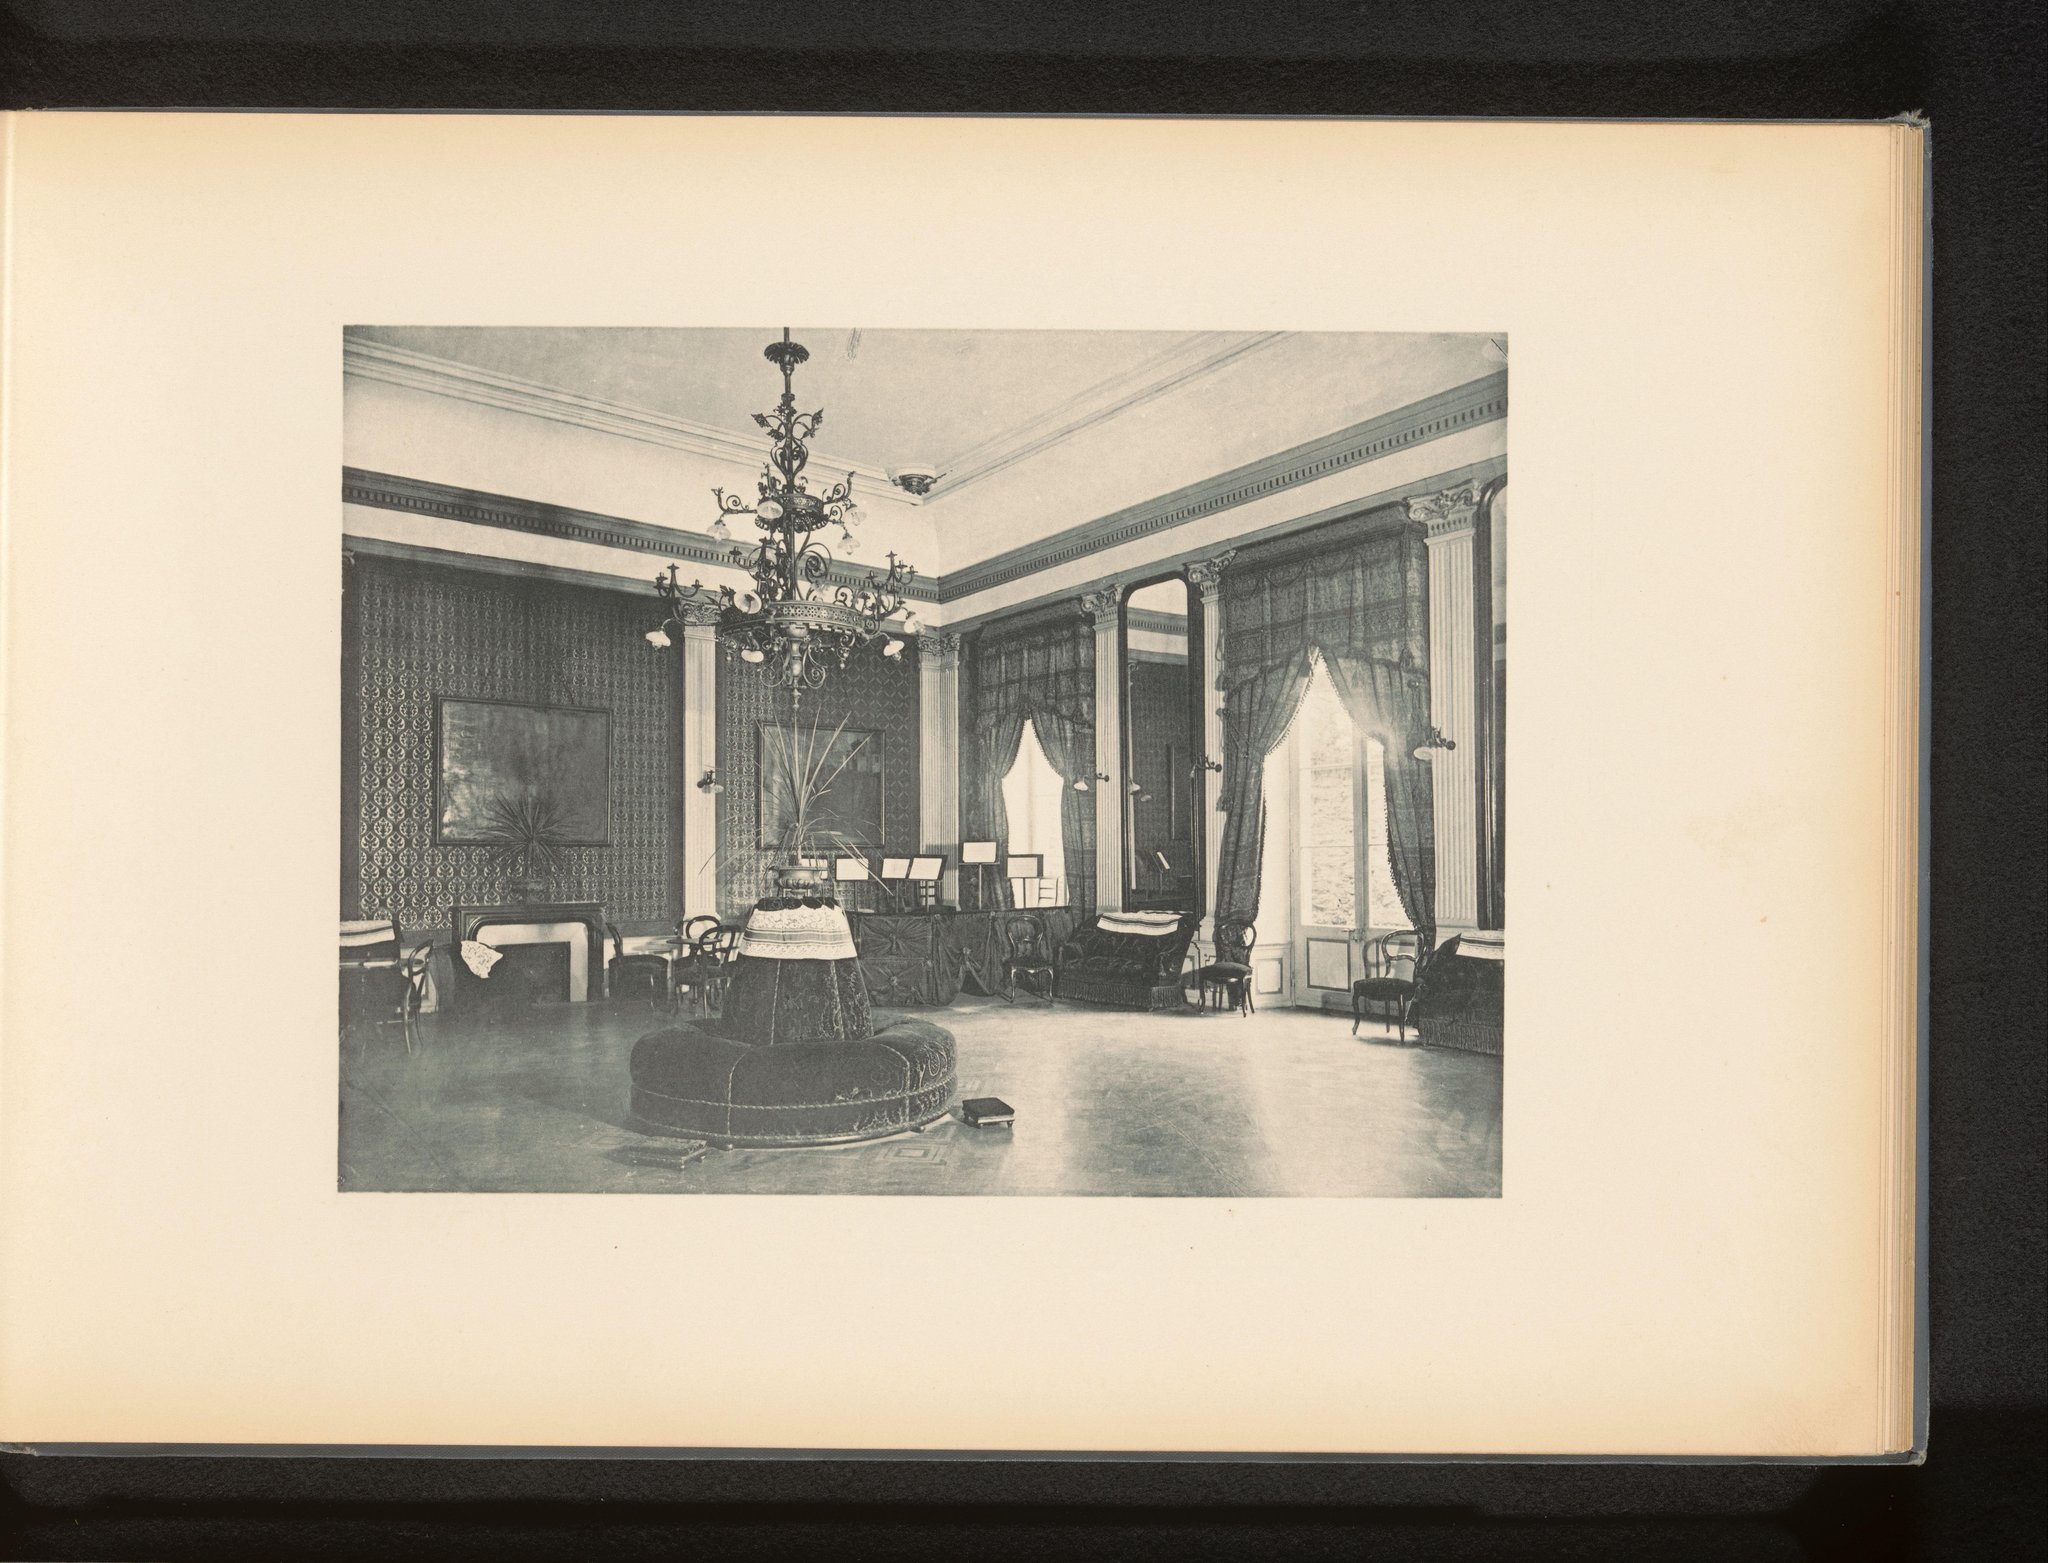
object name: photomechanical print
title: Gezicht op de salon van het hoofdgebouw van de baden van Heustrich-les-bains bij Spiez, Zwitserland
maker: Anonymous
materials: paper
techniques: photograph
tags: music-hall, public baths